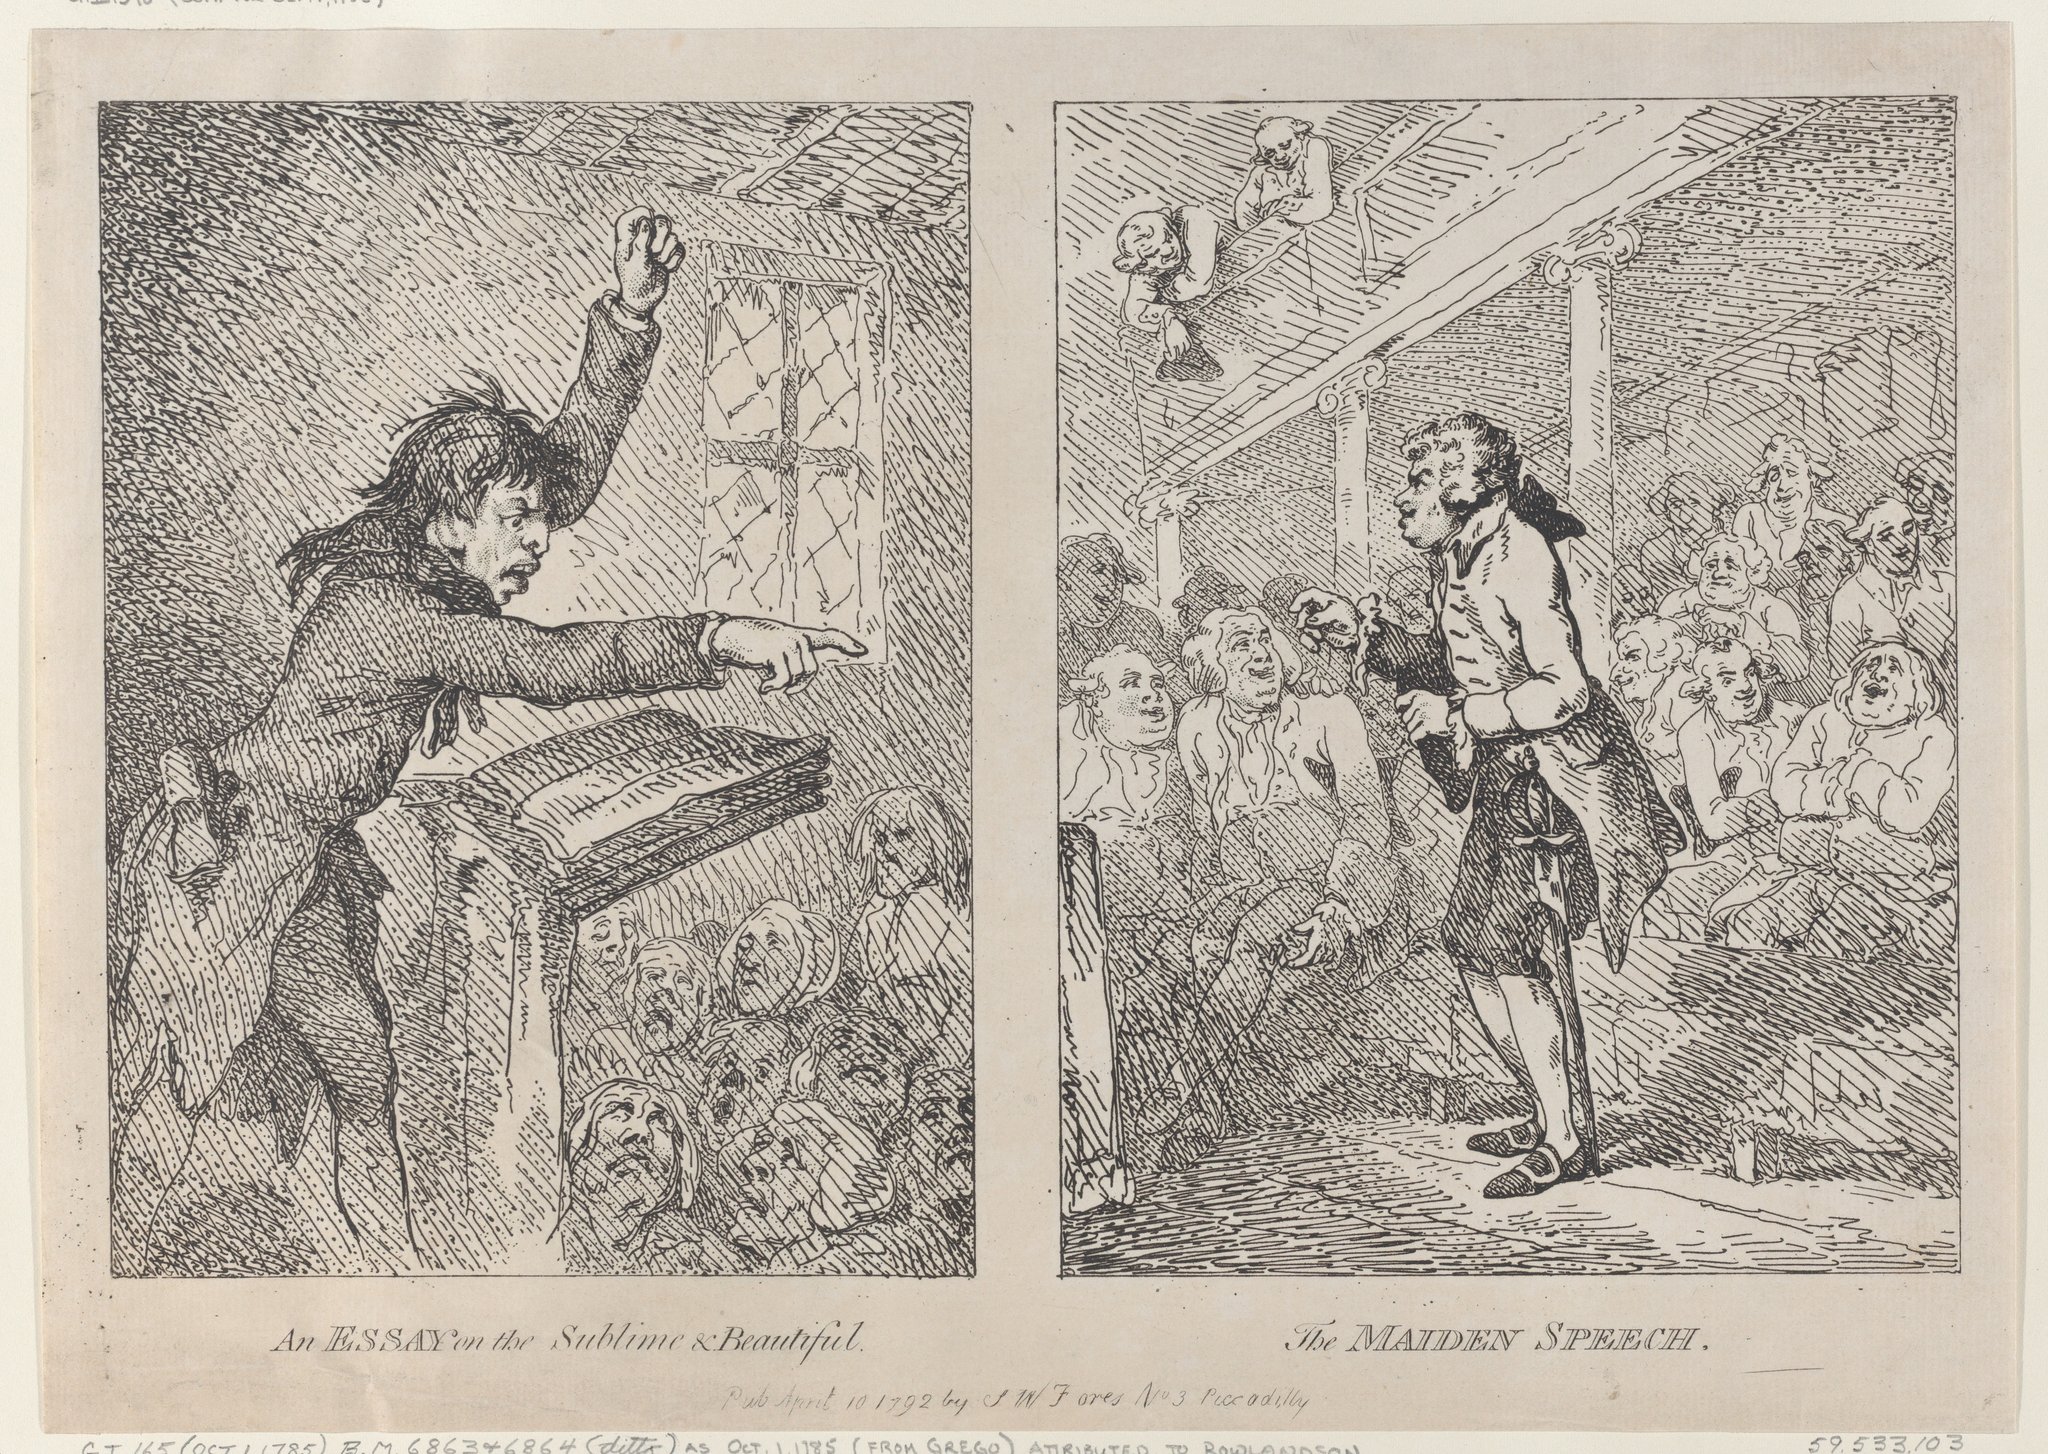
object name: print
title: An Essay on the Sublime & Beautiful; The Maiden Speech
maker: thomas rowlandson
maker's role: artist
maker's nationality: british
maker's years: 1757-1827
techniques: etching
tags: satire,men